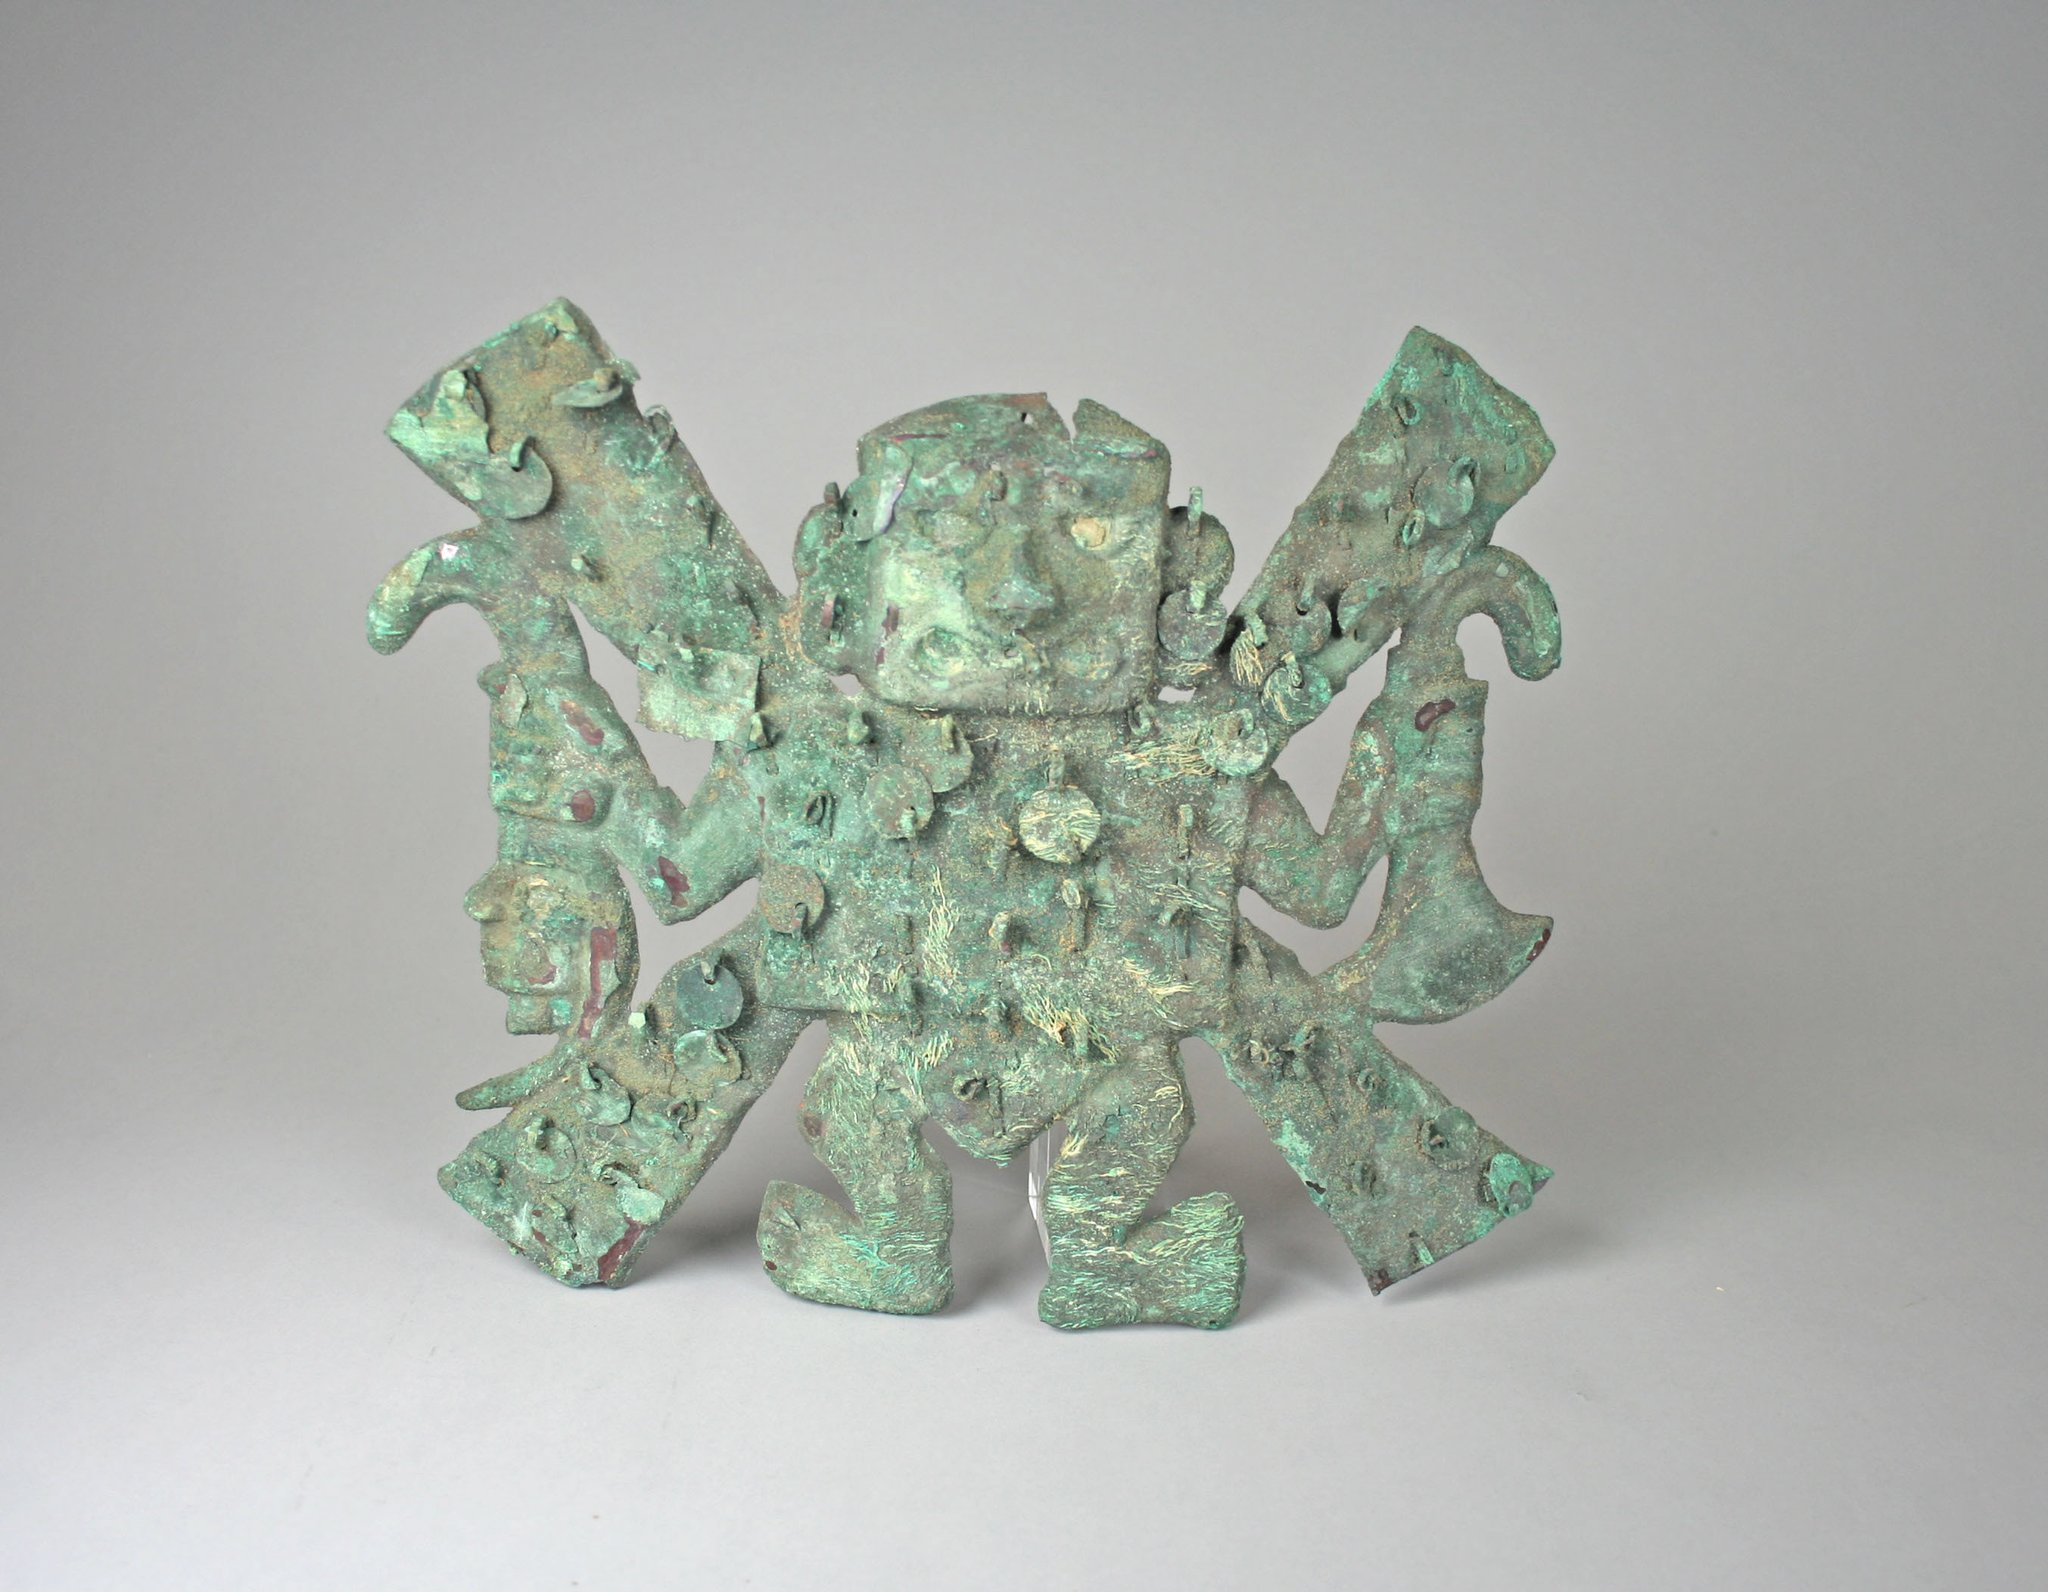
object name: ornament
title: Decapitator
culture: moche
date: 501-700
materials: metal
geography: peru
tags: men